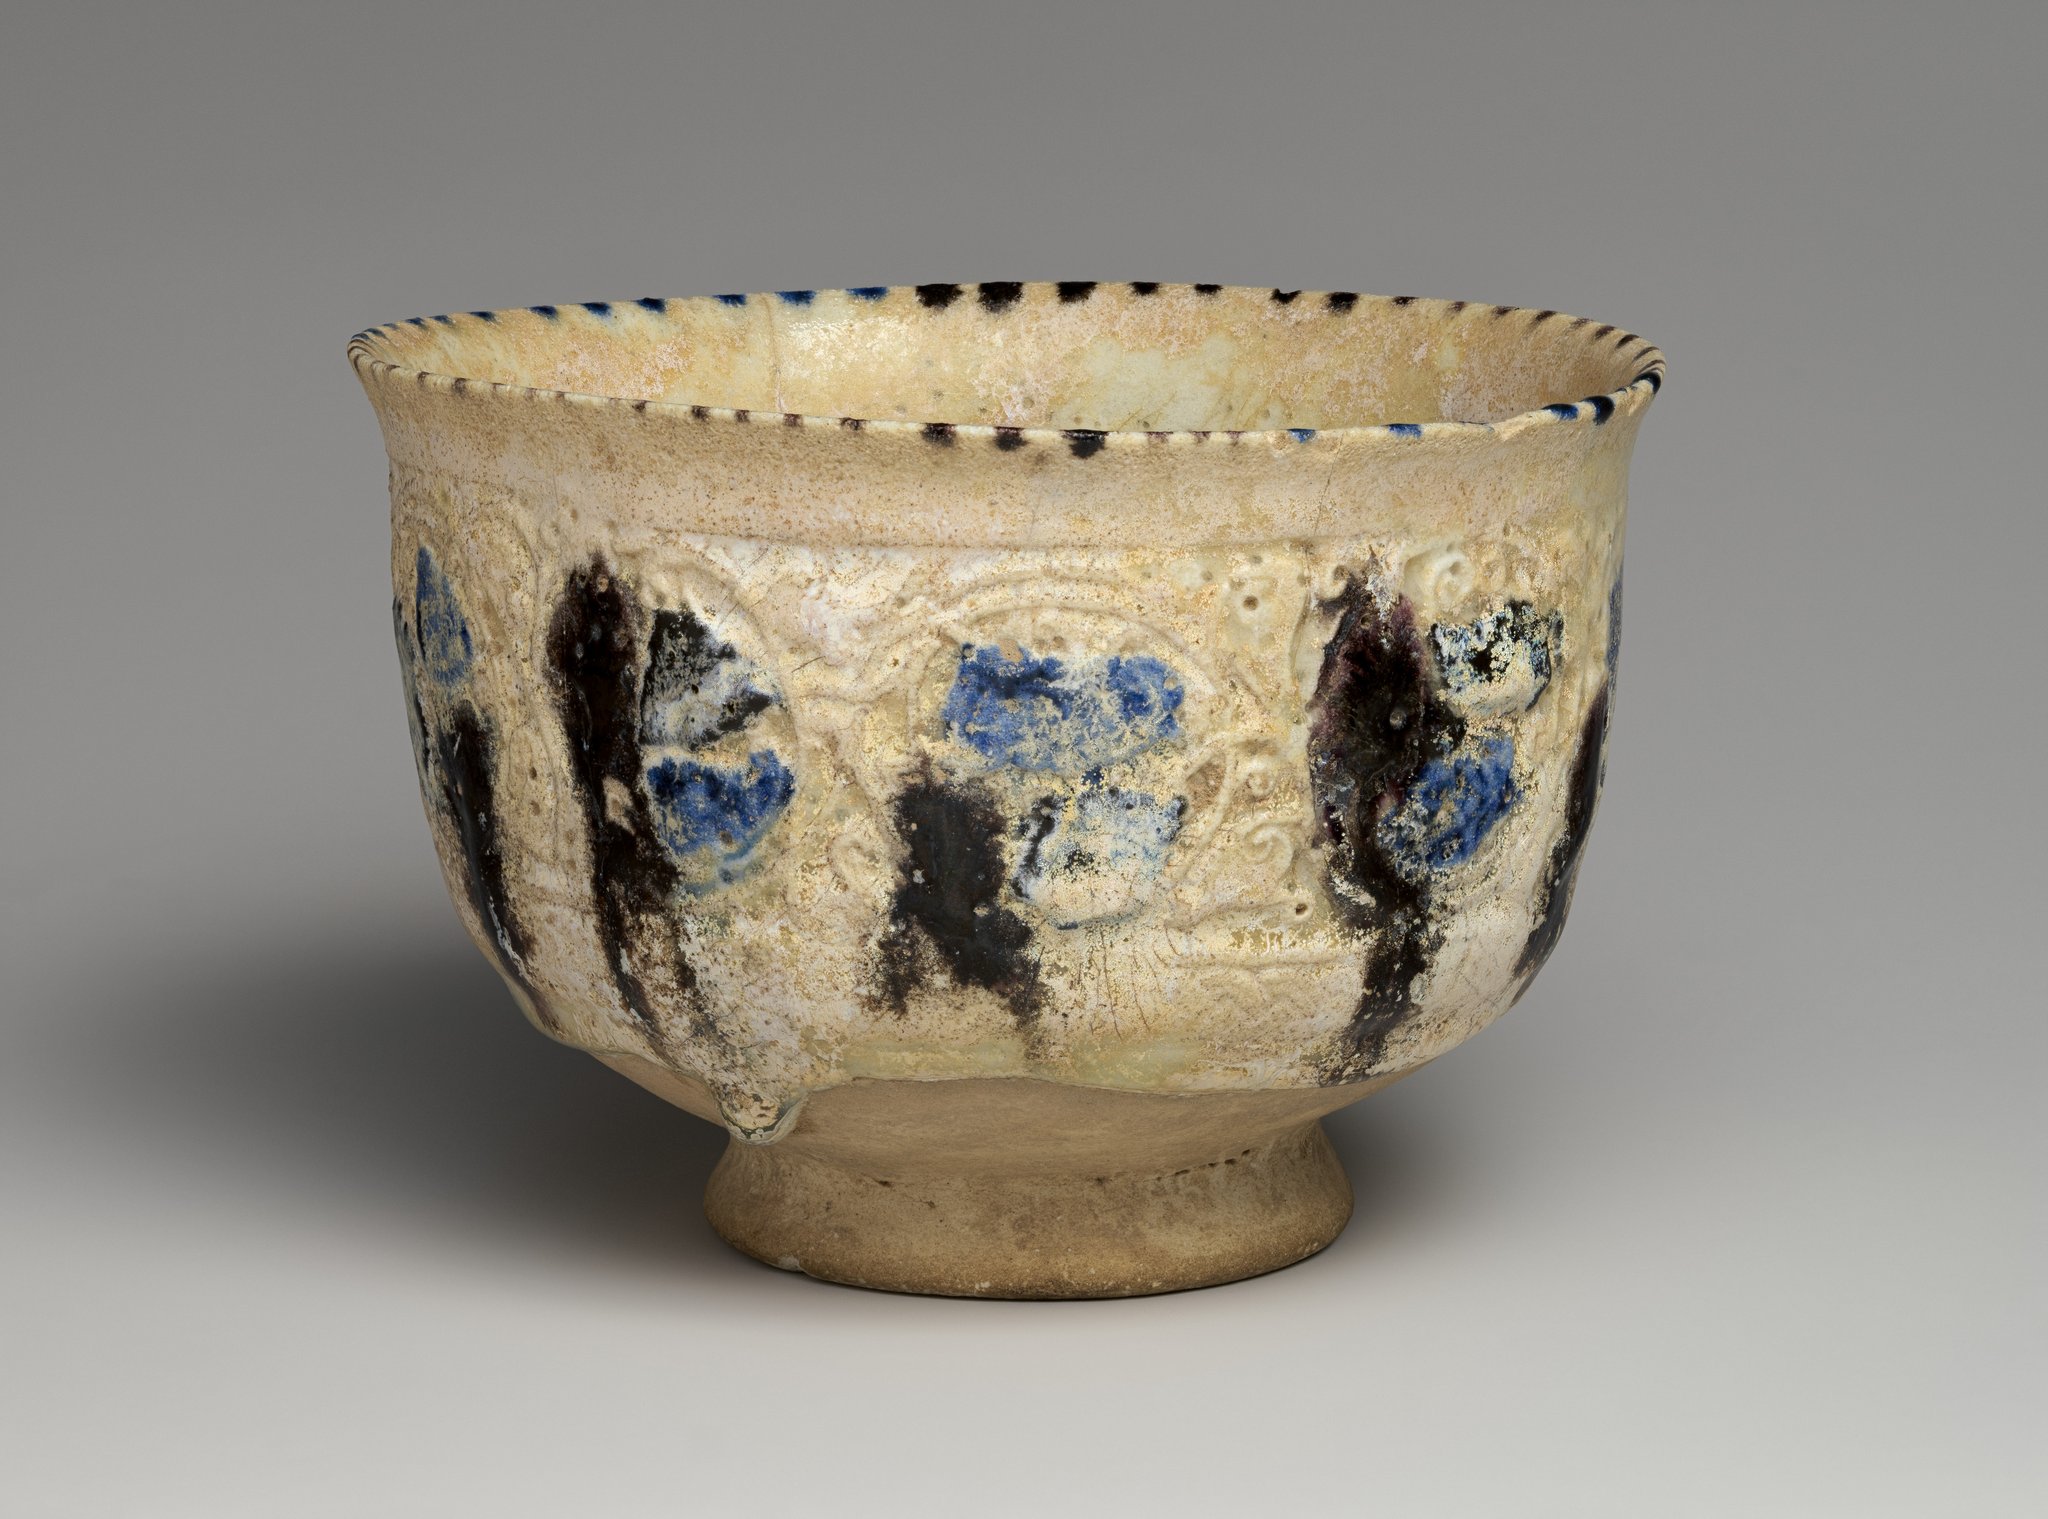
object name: bowl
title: Bowl with Revolving Scrolls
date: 1167-1200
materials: stonepaste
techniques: glazing, incising, molding, painting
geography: afghanistan